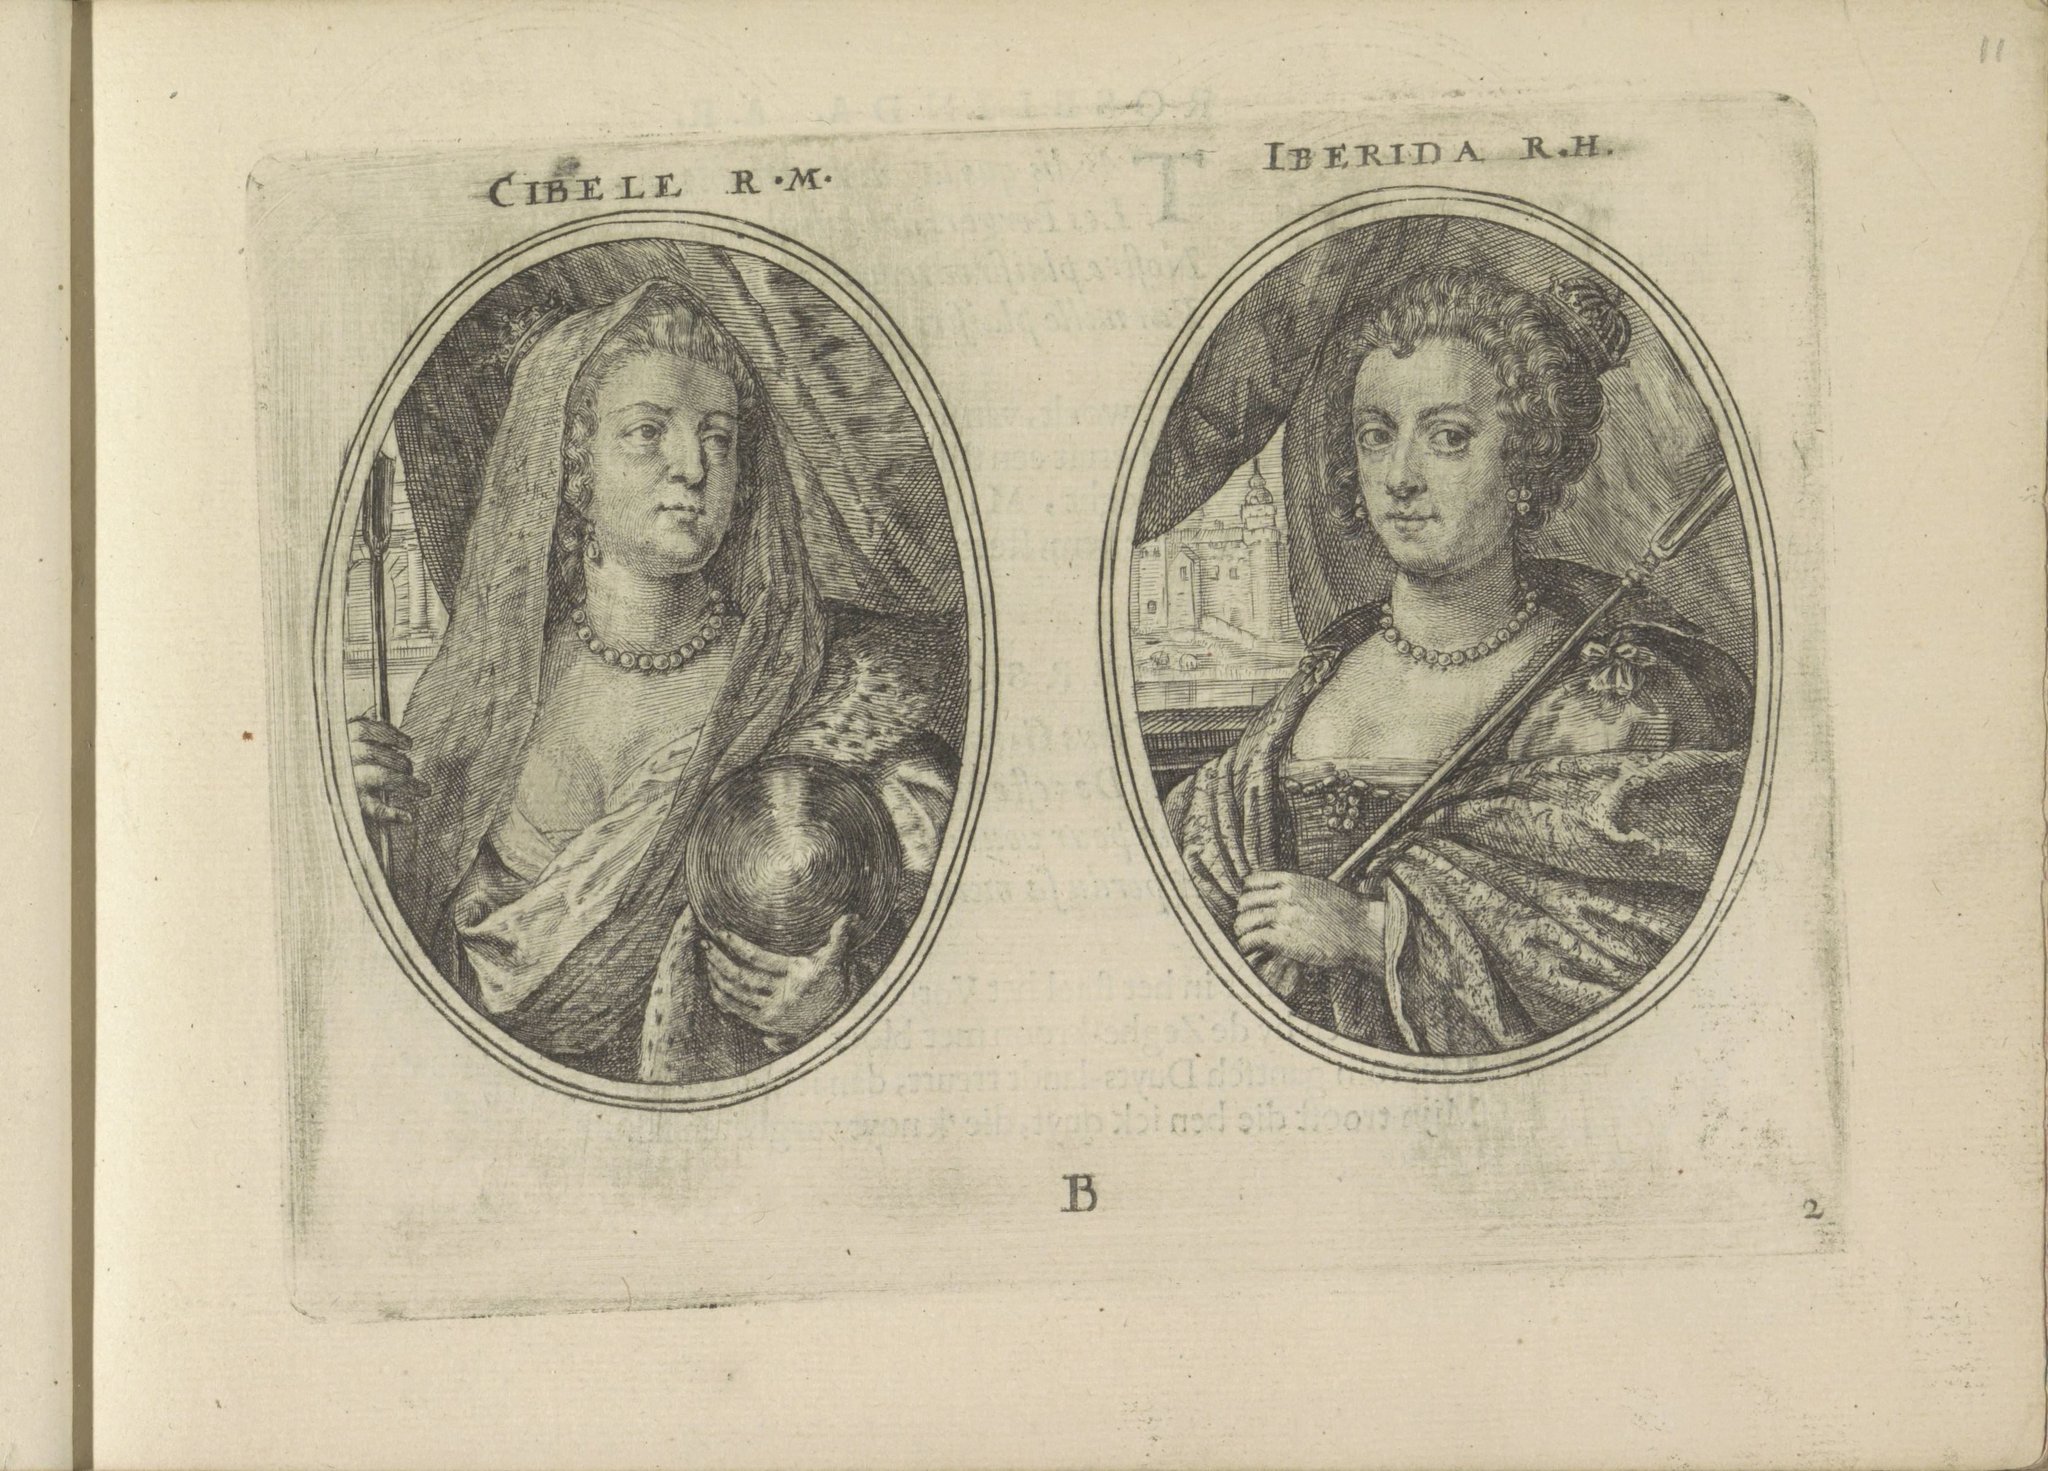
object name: print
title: Les vrais pourtraits de quelques unes des plus grandes dames de la chrestiente desguisees en bergeres.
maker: crispijn van de passe (ii)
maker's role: draughtsman, print maker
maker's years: 1594-1670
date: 1640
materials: paper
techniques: engraving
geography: amsterdam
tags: vienna, female sex; woman, shepherd's crook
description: Twee voorstellingen op een albumblad. Links het portret van Maria de' Medici als de aardmoeder Cybele. Rechts Elisabeth, koningin van Spanje, als Iberia. Beide vrouwen hebben een herdersstaf in de hand. Op de achtergrond van beide voorstellingen respectievelijk een stadspoort en een kasteel. Onderaan genummerd: B en 2. Het blad maakt deel uit van een album.